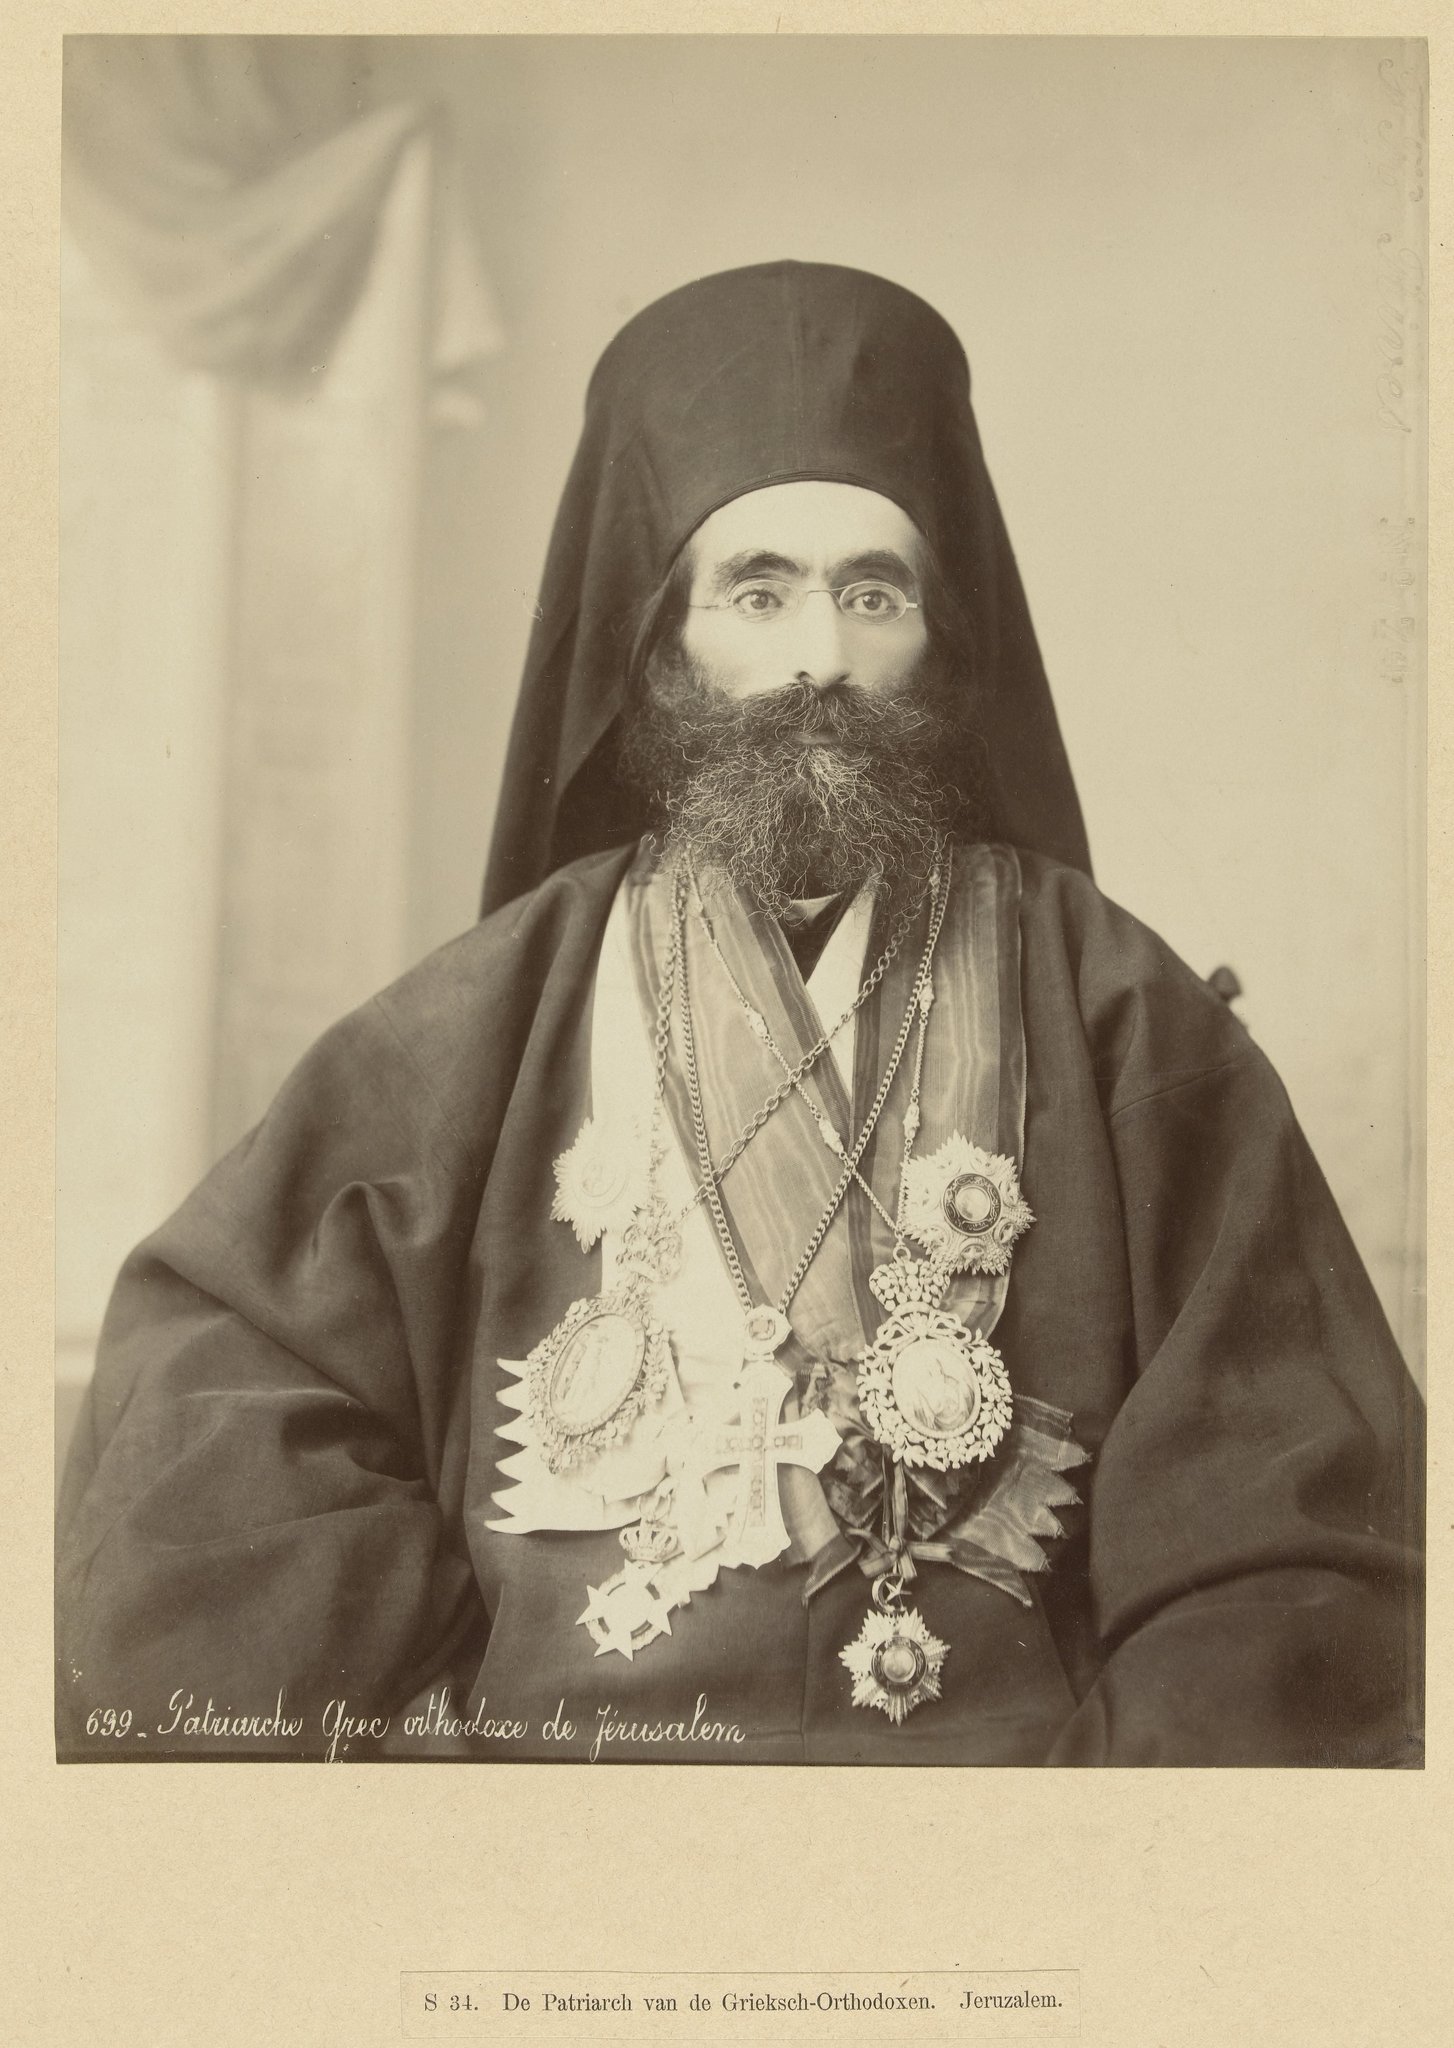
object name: photograph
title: S 34. De Patriarch van de Grieksch-Orthodoxen. Jeruzalem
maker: Anonymous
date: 1891-1895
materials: cardboard, paper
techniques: albumen print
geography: jerusalem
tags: greek orthodox church, historical persons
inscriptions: watermark: ‘FK Rives No 74’, title: ‘S 34. De Patriarch van de Grieksch-Orthodoxen. Jeruzalem.’, number: ‘699’, stamp: ‘Gemeentelijke bibliotheek/ Rotterdam’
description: Onderdeel van een groep door fotograaf Richard Polak op reis verzamelde foto’s. Deze foto is samen met andere op zijn reizen verzamelde foto's tentoongesteld bij de Rotterdamsche Kunstkring (1895), Arti en Amicitiae te Amsterdam (1897-1898?) en Societeit 't Collegie te Kampen (datum vooralsnog onbekend).